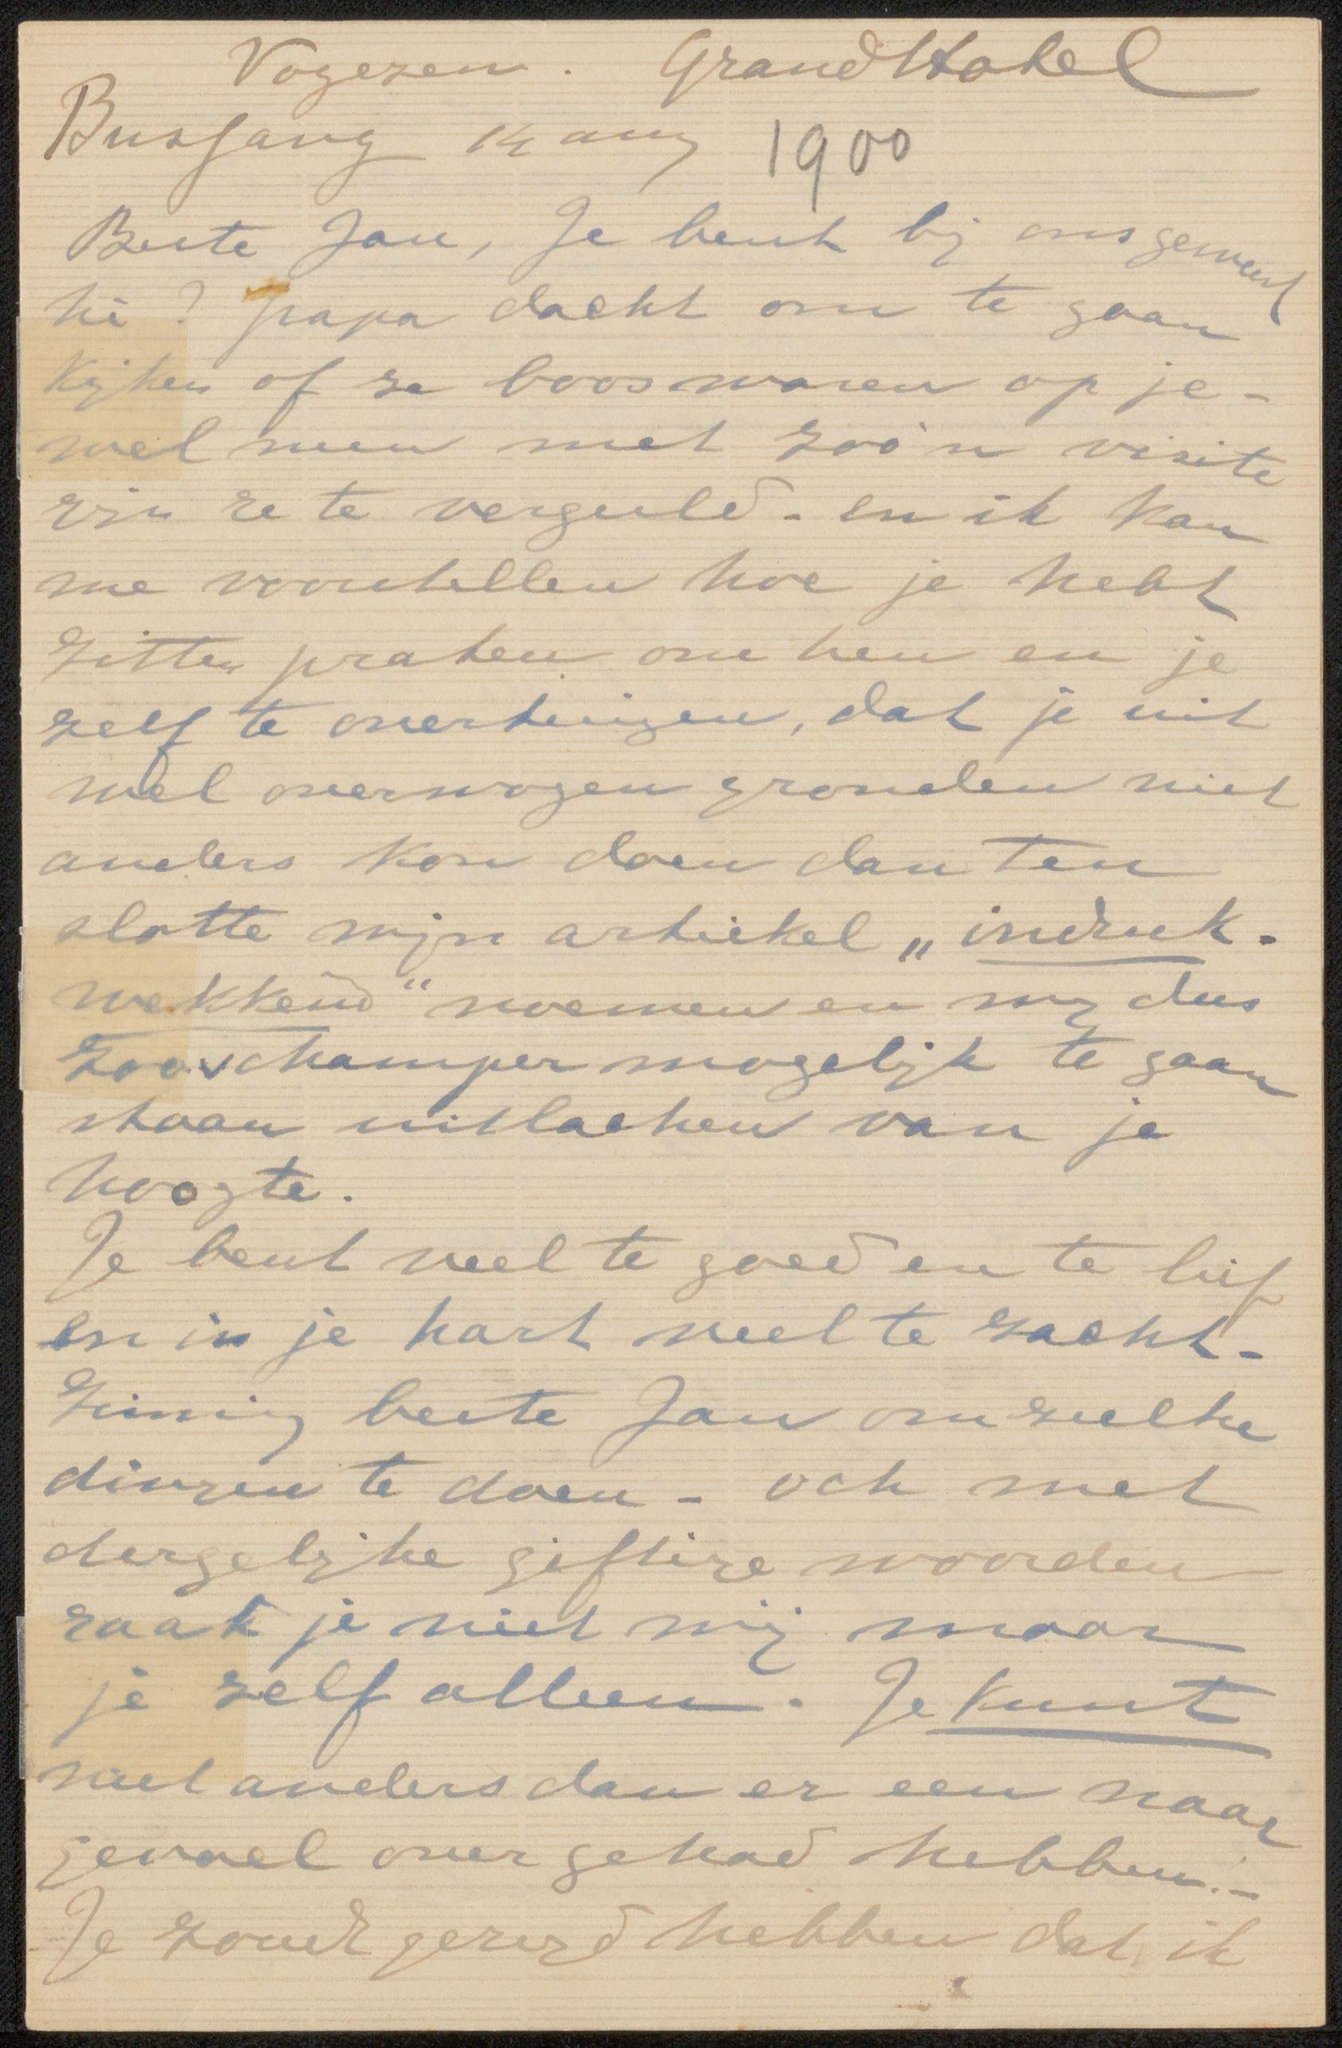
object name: letter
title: Brief aan Jan Veth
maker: etha fles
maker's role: print maker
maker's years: 1857-1948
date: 1874-1925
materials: ink, paper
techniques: pen, writing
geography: bussang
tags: dordrecht, amsterdam, painter, print maker, draughtsman, designer, jan veth, printed matter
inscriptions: collector's mark: ‘RPK’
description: Brief gedateerd 14 aug door schrijver, met toevoeging 1900 in latere hand.